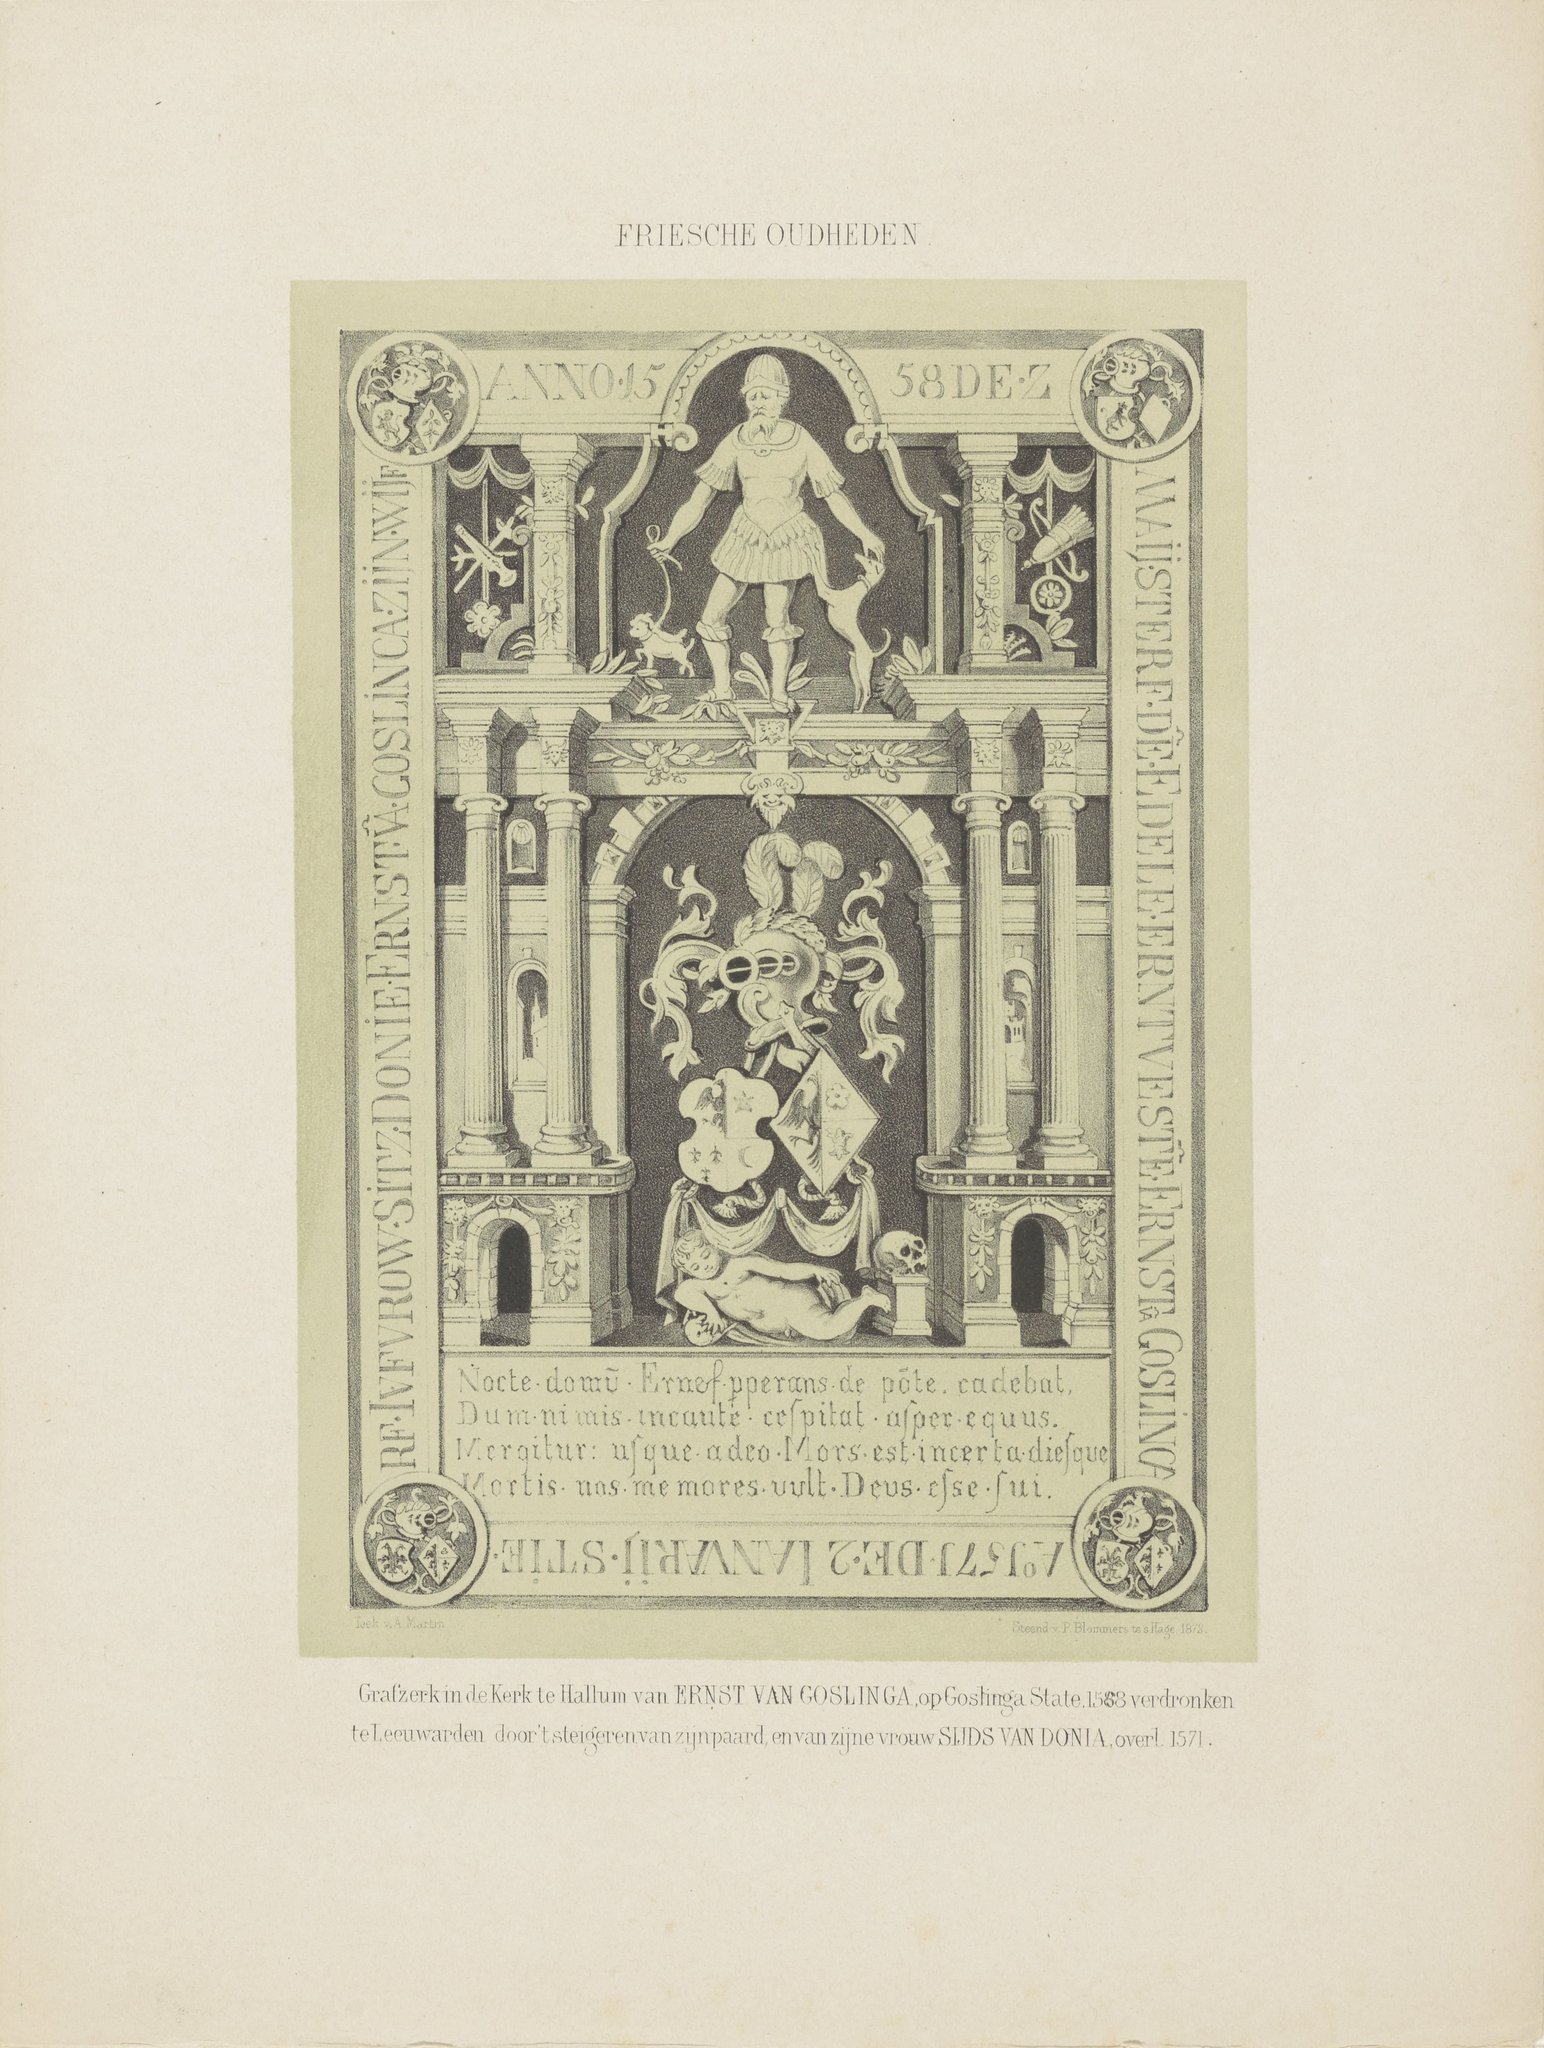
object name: print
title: Grafzerk in de kerk van Hallum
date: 1872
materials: paper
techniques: tone lithography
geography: the hague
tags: sleeping; unconsciousness, cupids: 'amores', 'amoretti', 'putti', armorial bearing, heraldry, flat, horizontal gravestone, death's head, skull (symbol of death)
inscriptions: collector's mark: Lugt 2228, inscription: ‘5’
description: Prent uit: S.n. Friesche oudheden. Afbeeldingen van merkwaardige voorwerpen van wetenschap en kunst gevonden in de archieven, kerken, kasteelen, terpen enz. van Friesland. Leeuwarden: Kuipers, H., 1875.